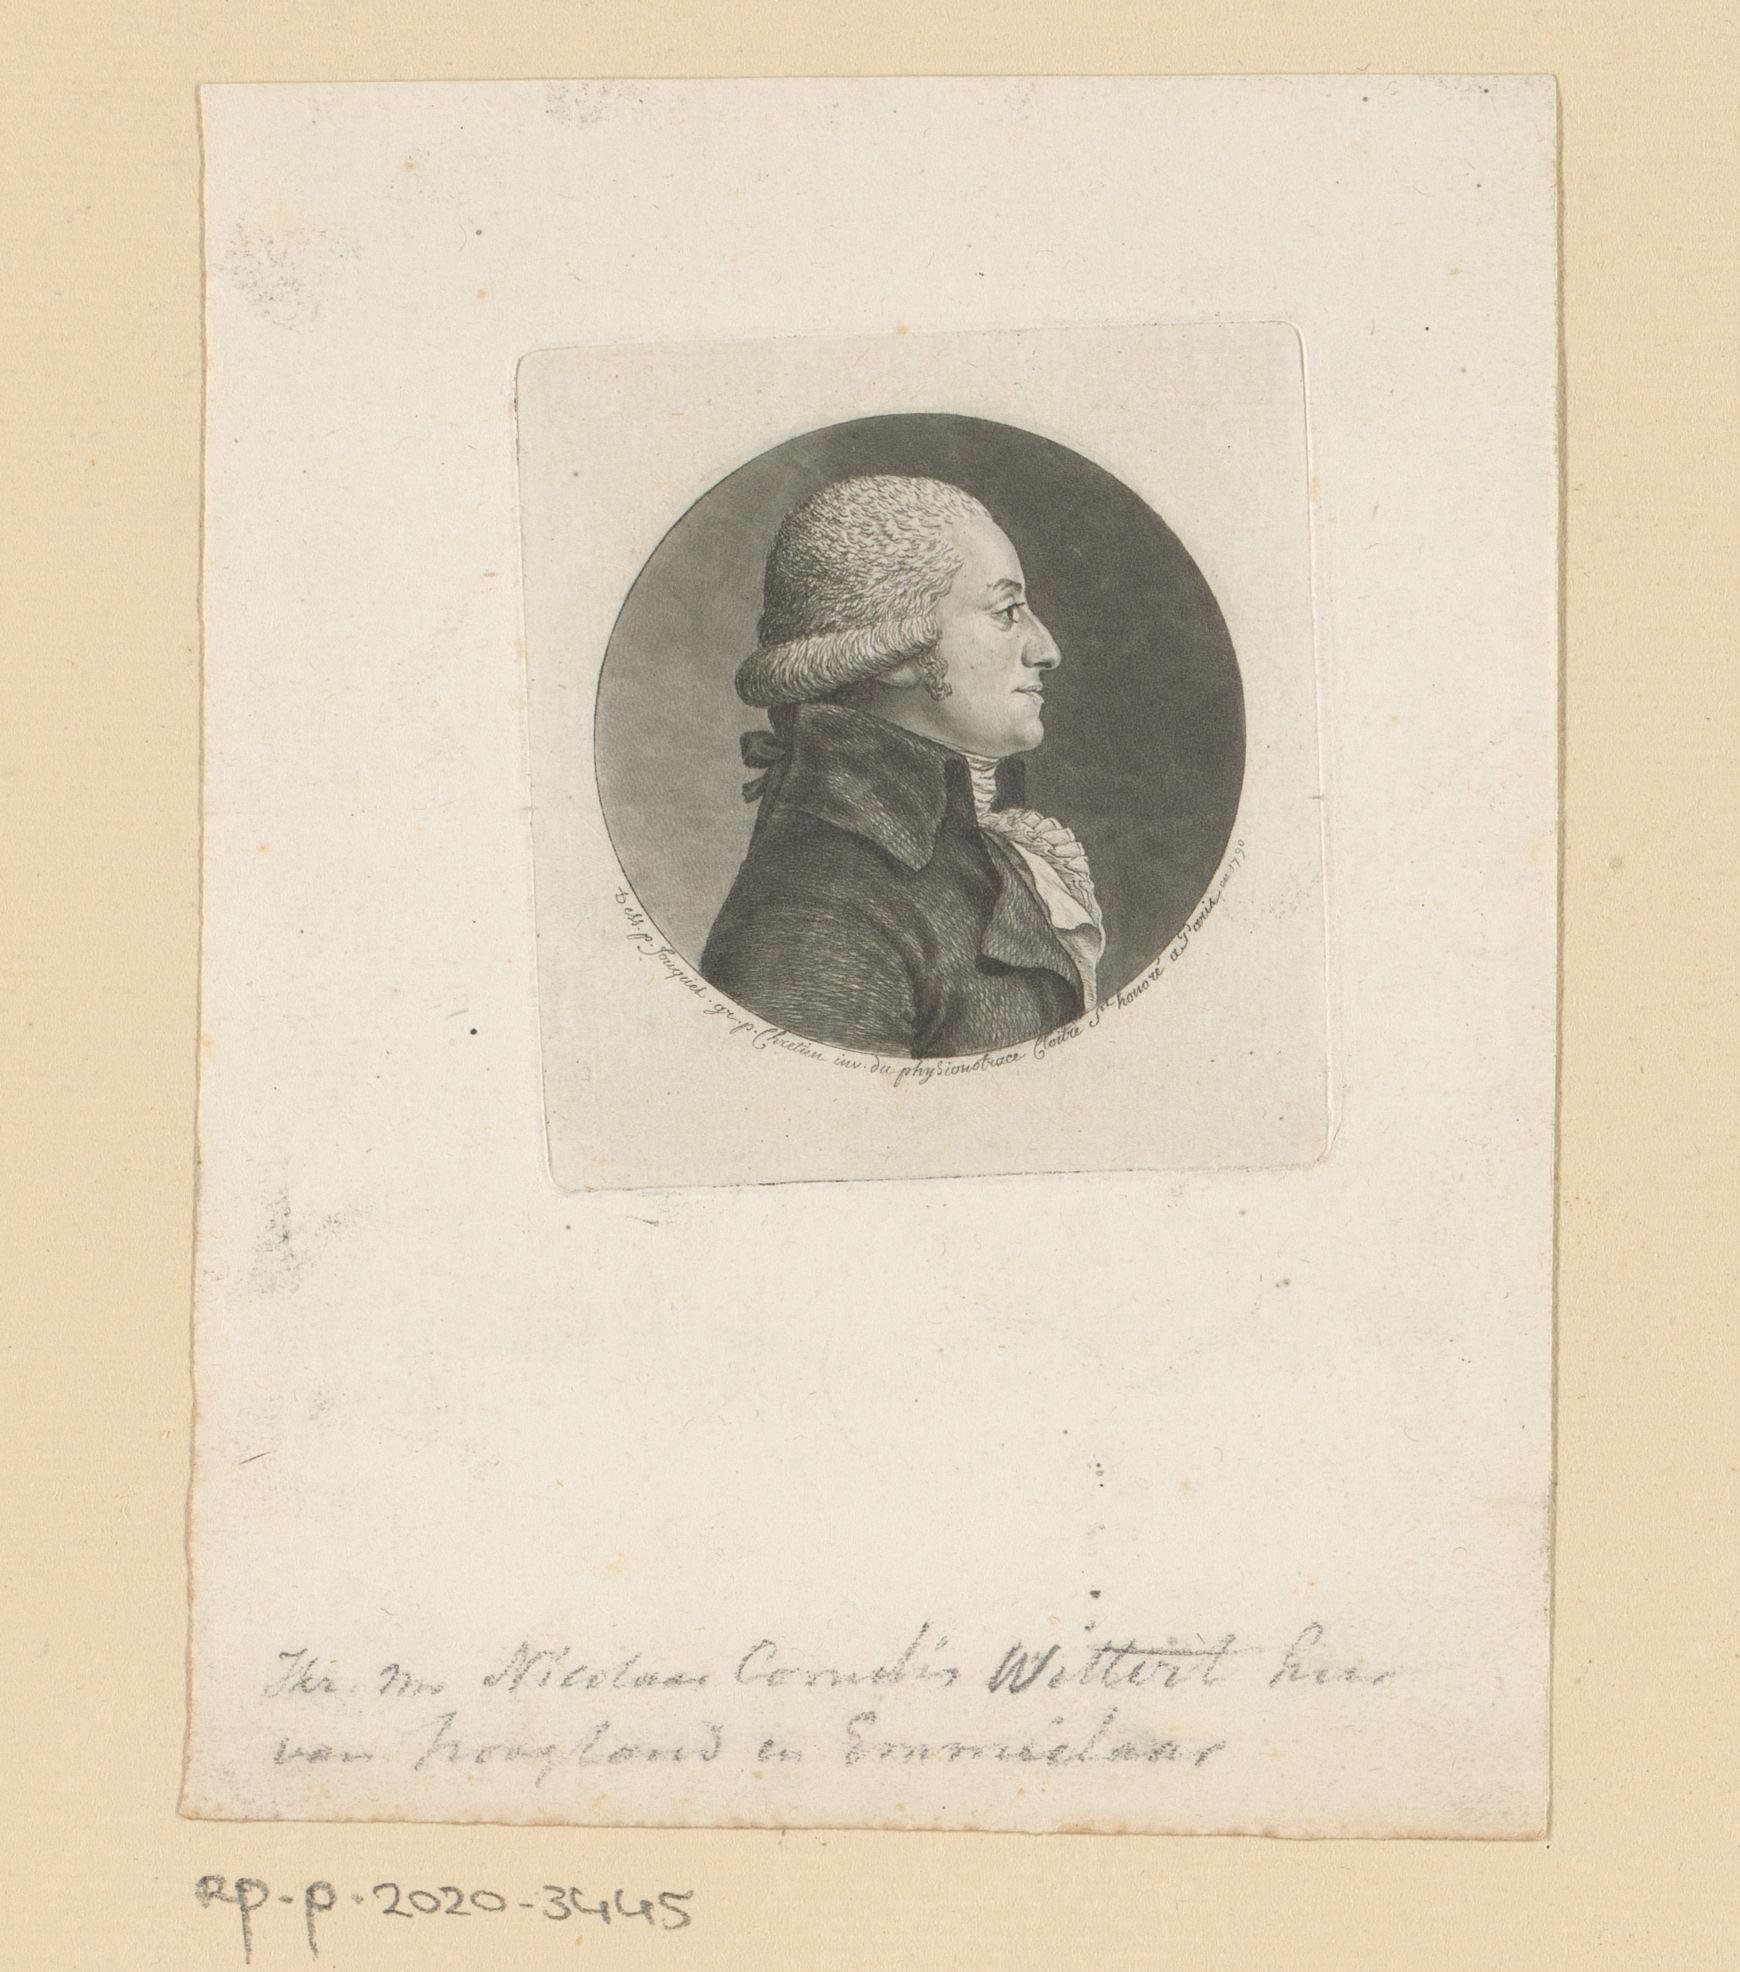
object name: print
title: Portret van jonkheer Nicolaas Cornelis Wittert van Hoogland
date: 1790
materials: paper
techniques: aquatint, etching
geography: paris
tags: amsterdam, the hague, politician, silhouette-apparatus, 'physionotrace', historical persons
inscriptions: collector's mark: Lugt 2228